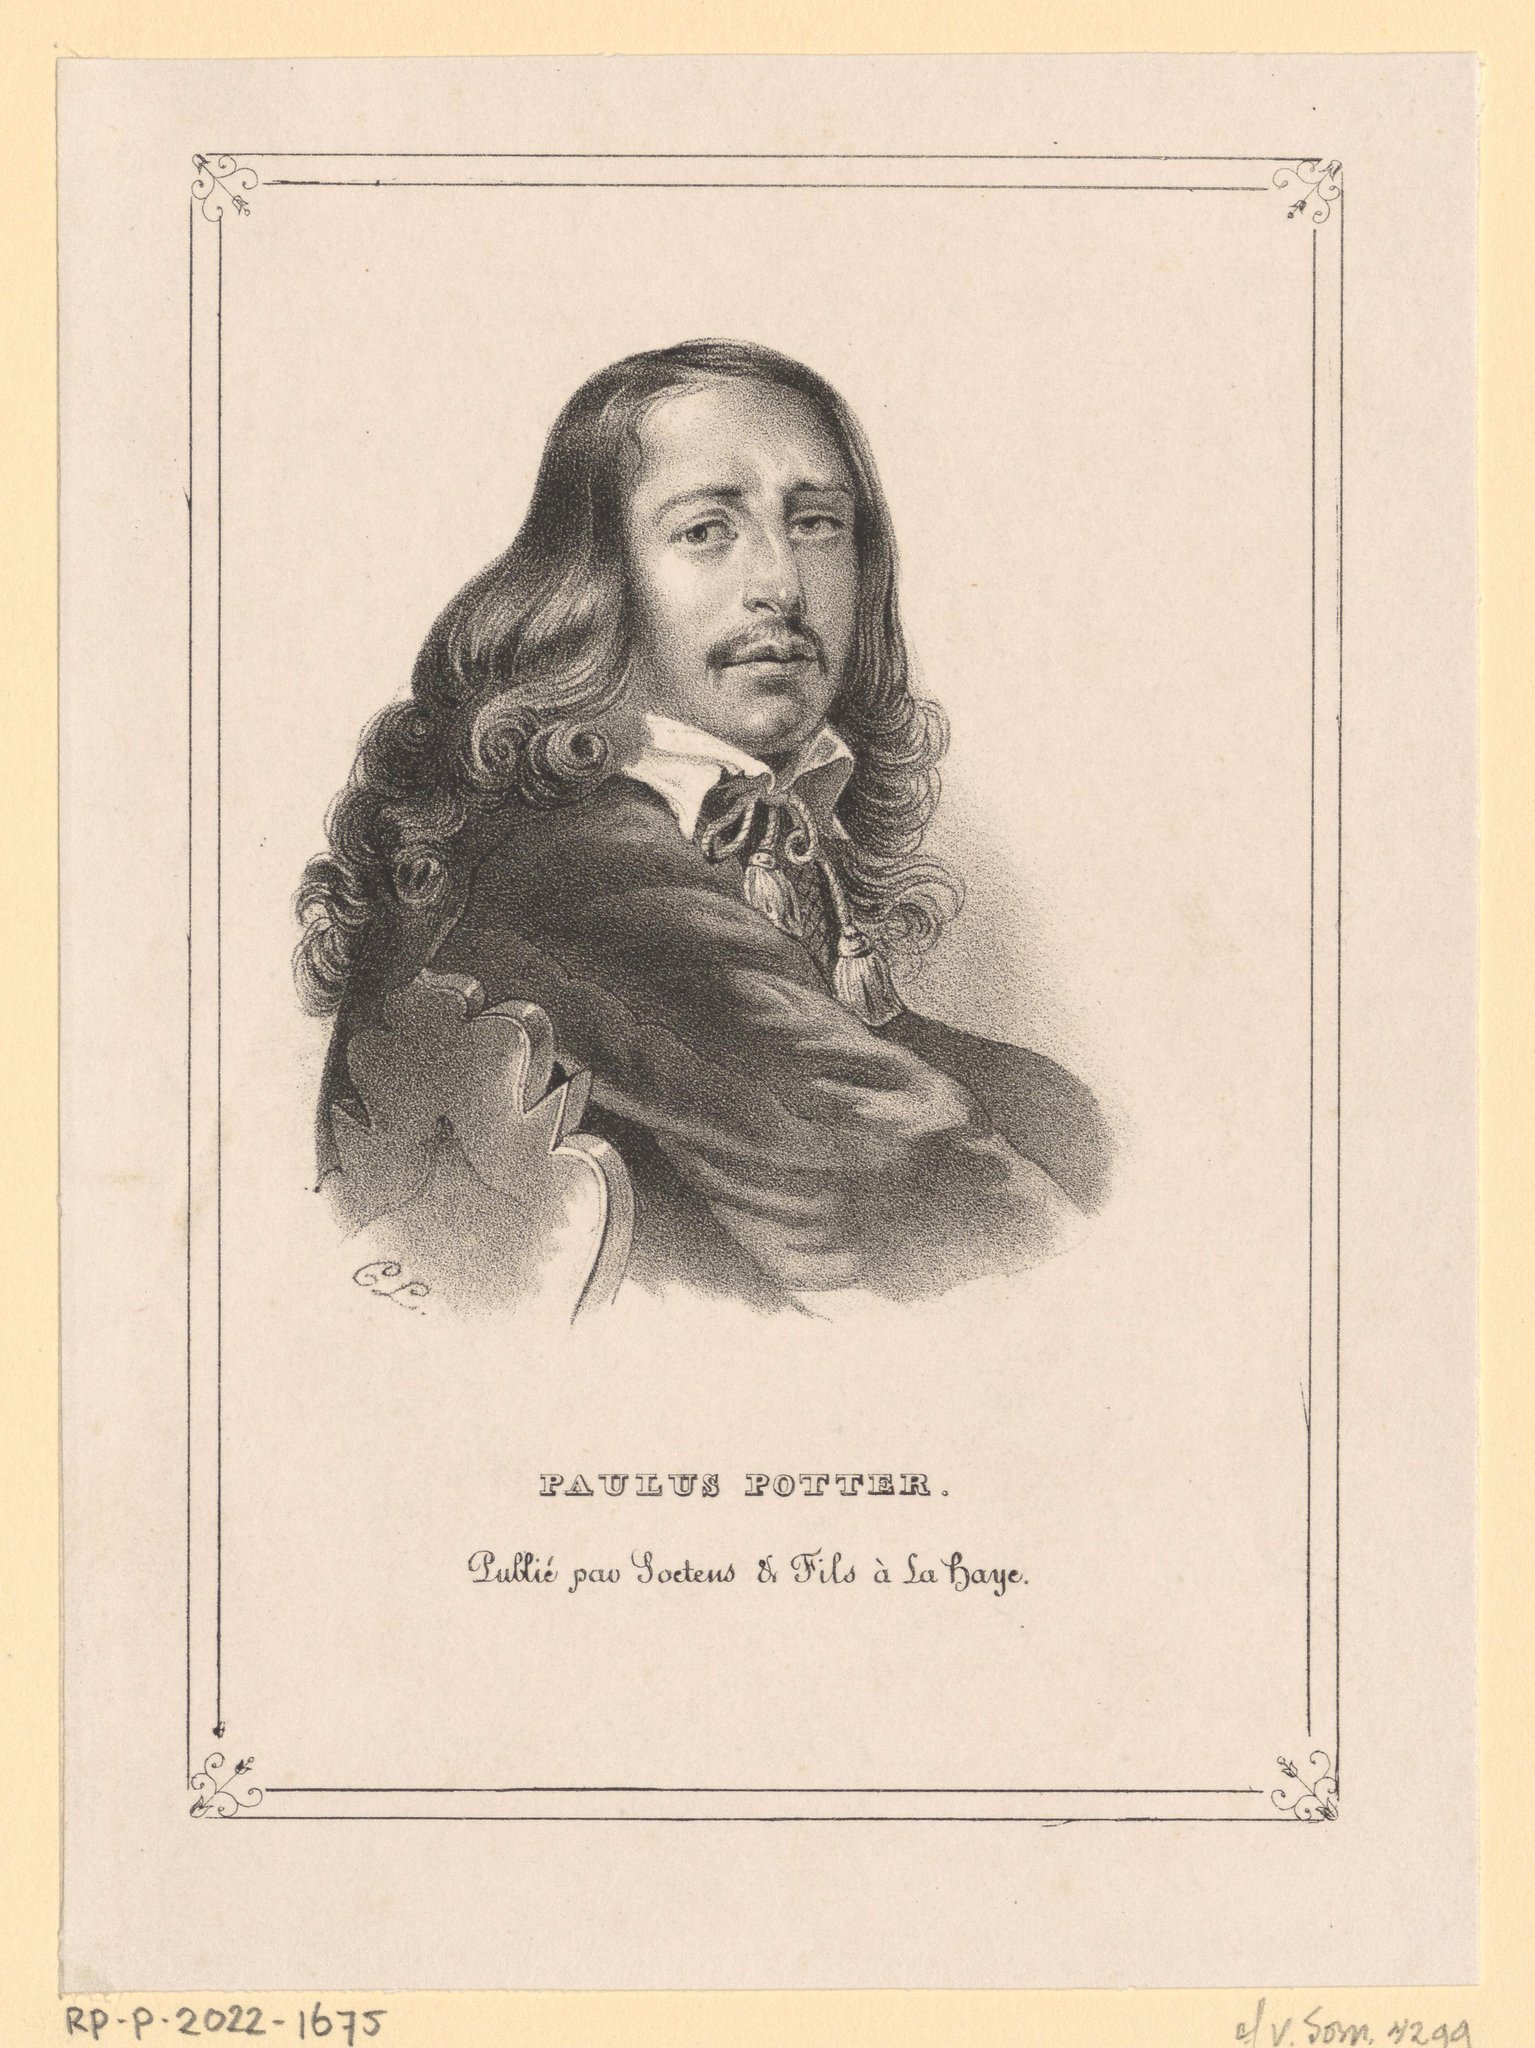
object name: print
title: Serie portretten door Soetens & Fils omstreeks 1838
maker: carel christiaan antony last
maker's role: print maker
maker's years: 1808-1876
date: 1839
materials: paper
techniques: lithograph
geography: the hague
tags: enkhuizen, painter, print maker, draughtsman, paulus potter, historical persons, portrait, self-portrait of artist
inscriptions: inscription: ‘geb te Enkhuizen (...) N Z Kapel’